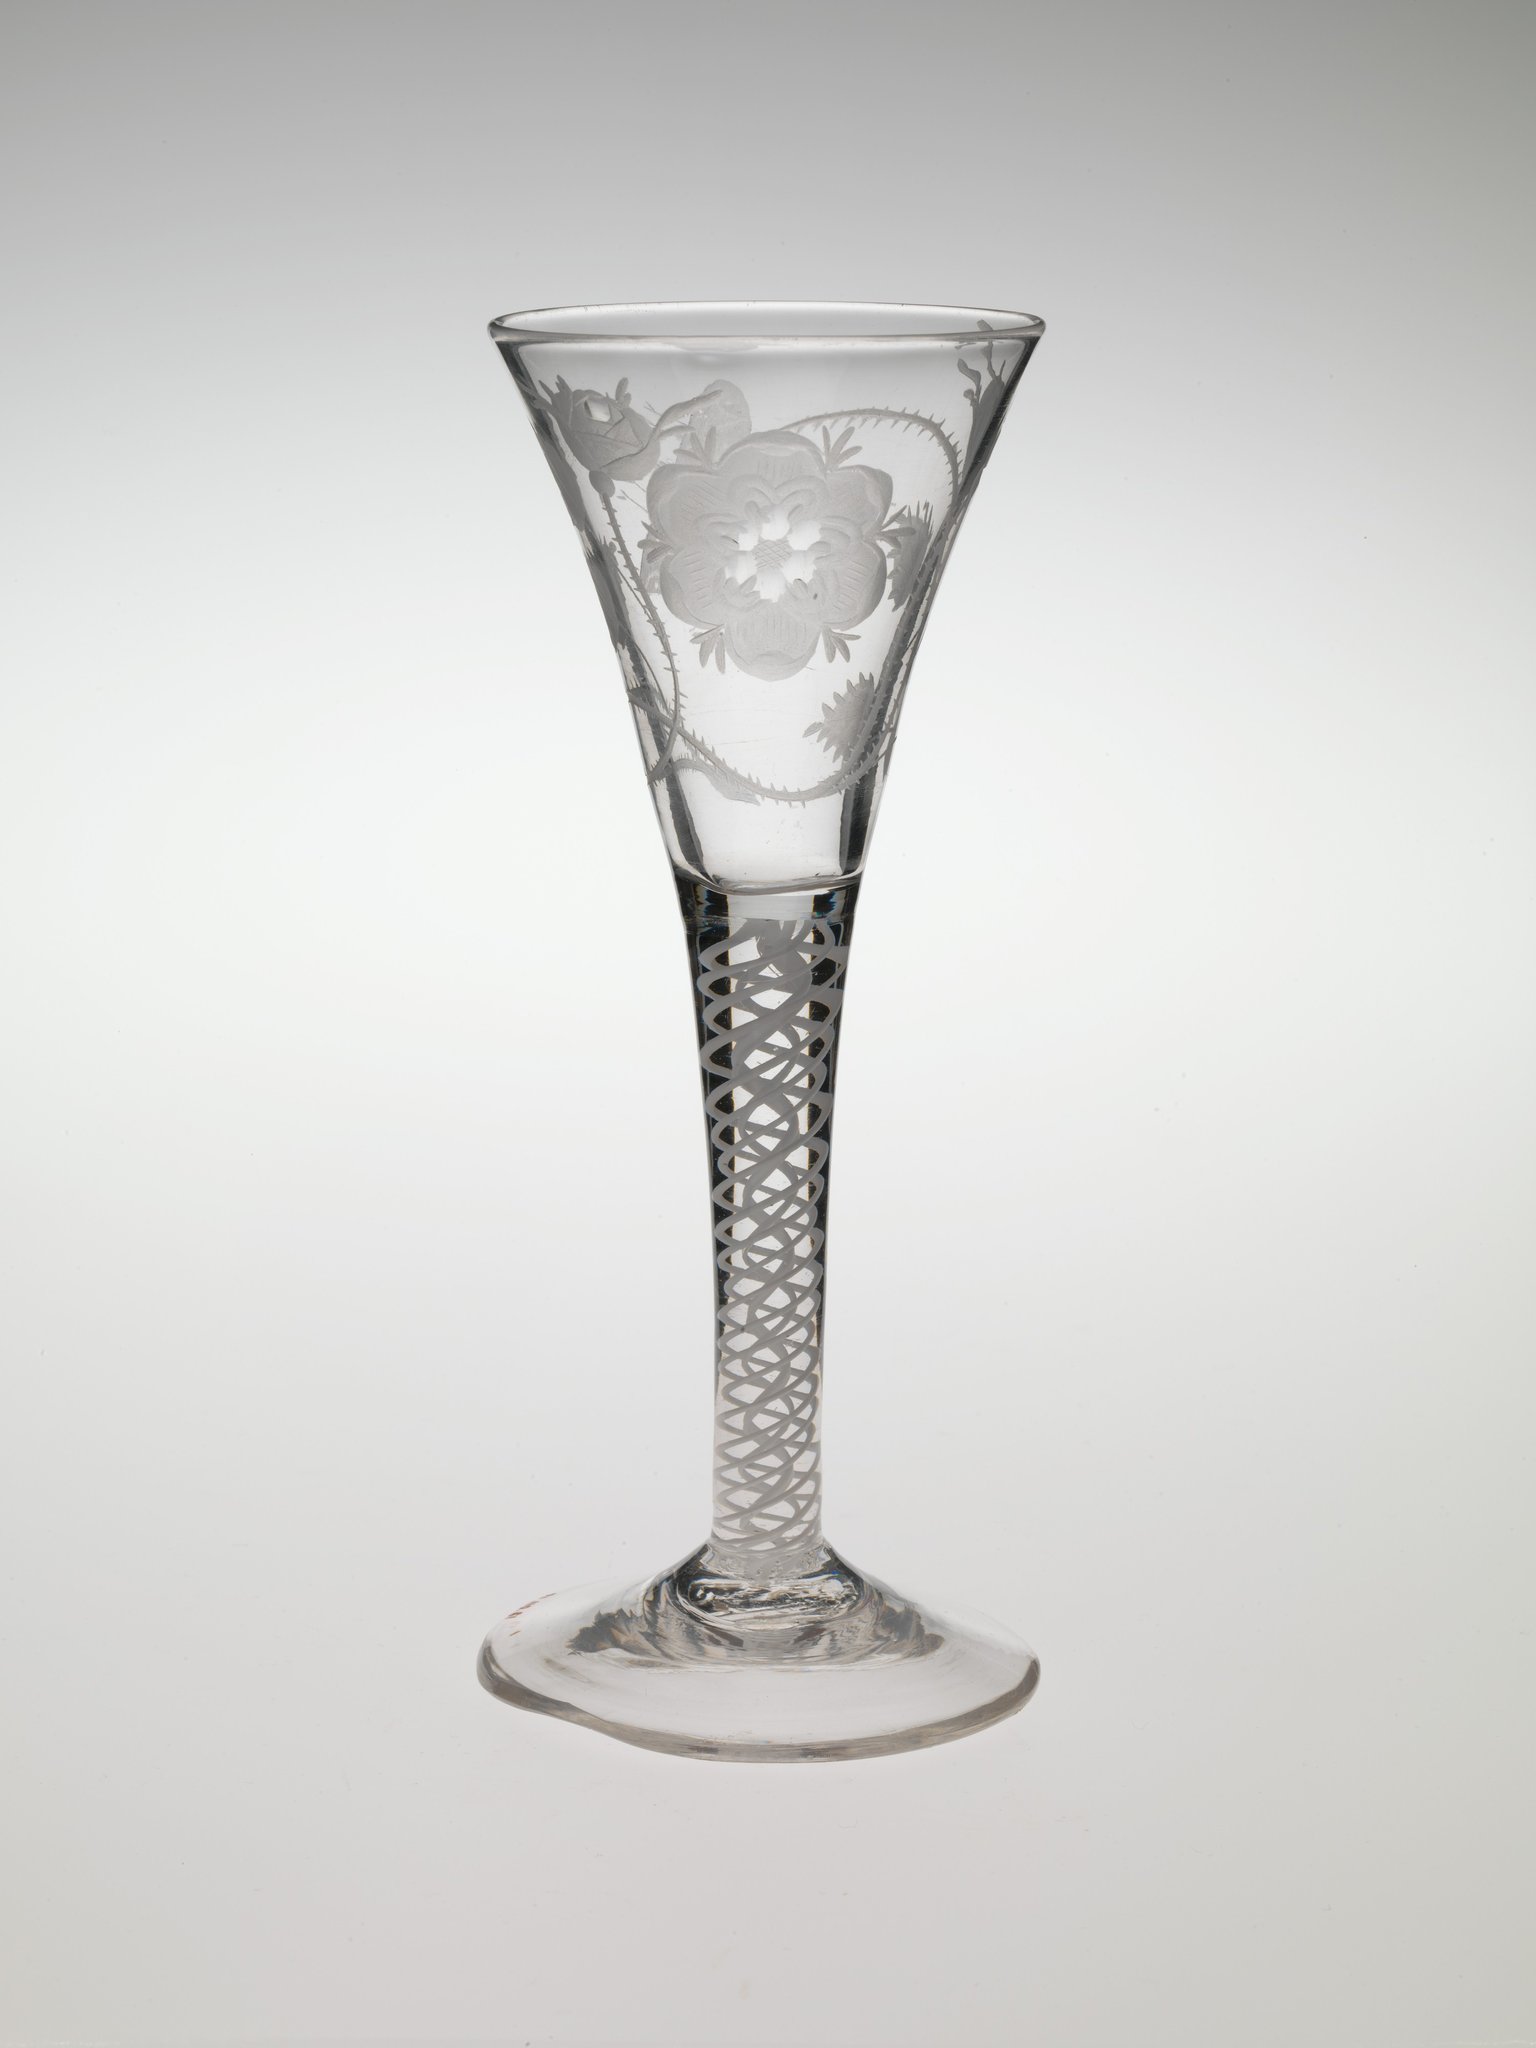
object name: wineglass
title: Wineglass with Jacobite emblems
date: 1745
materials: glass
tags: butterflies,flowers